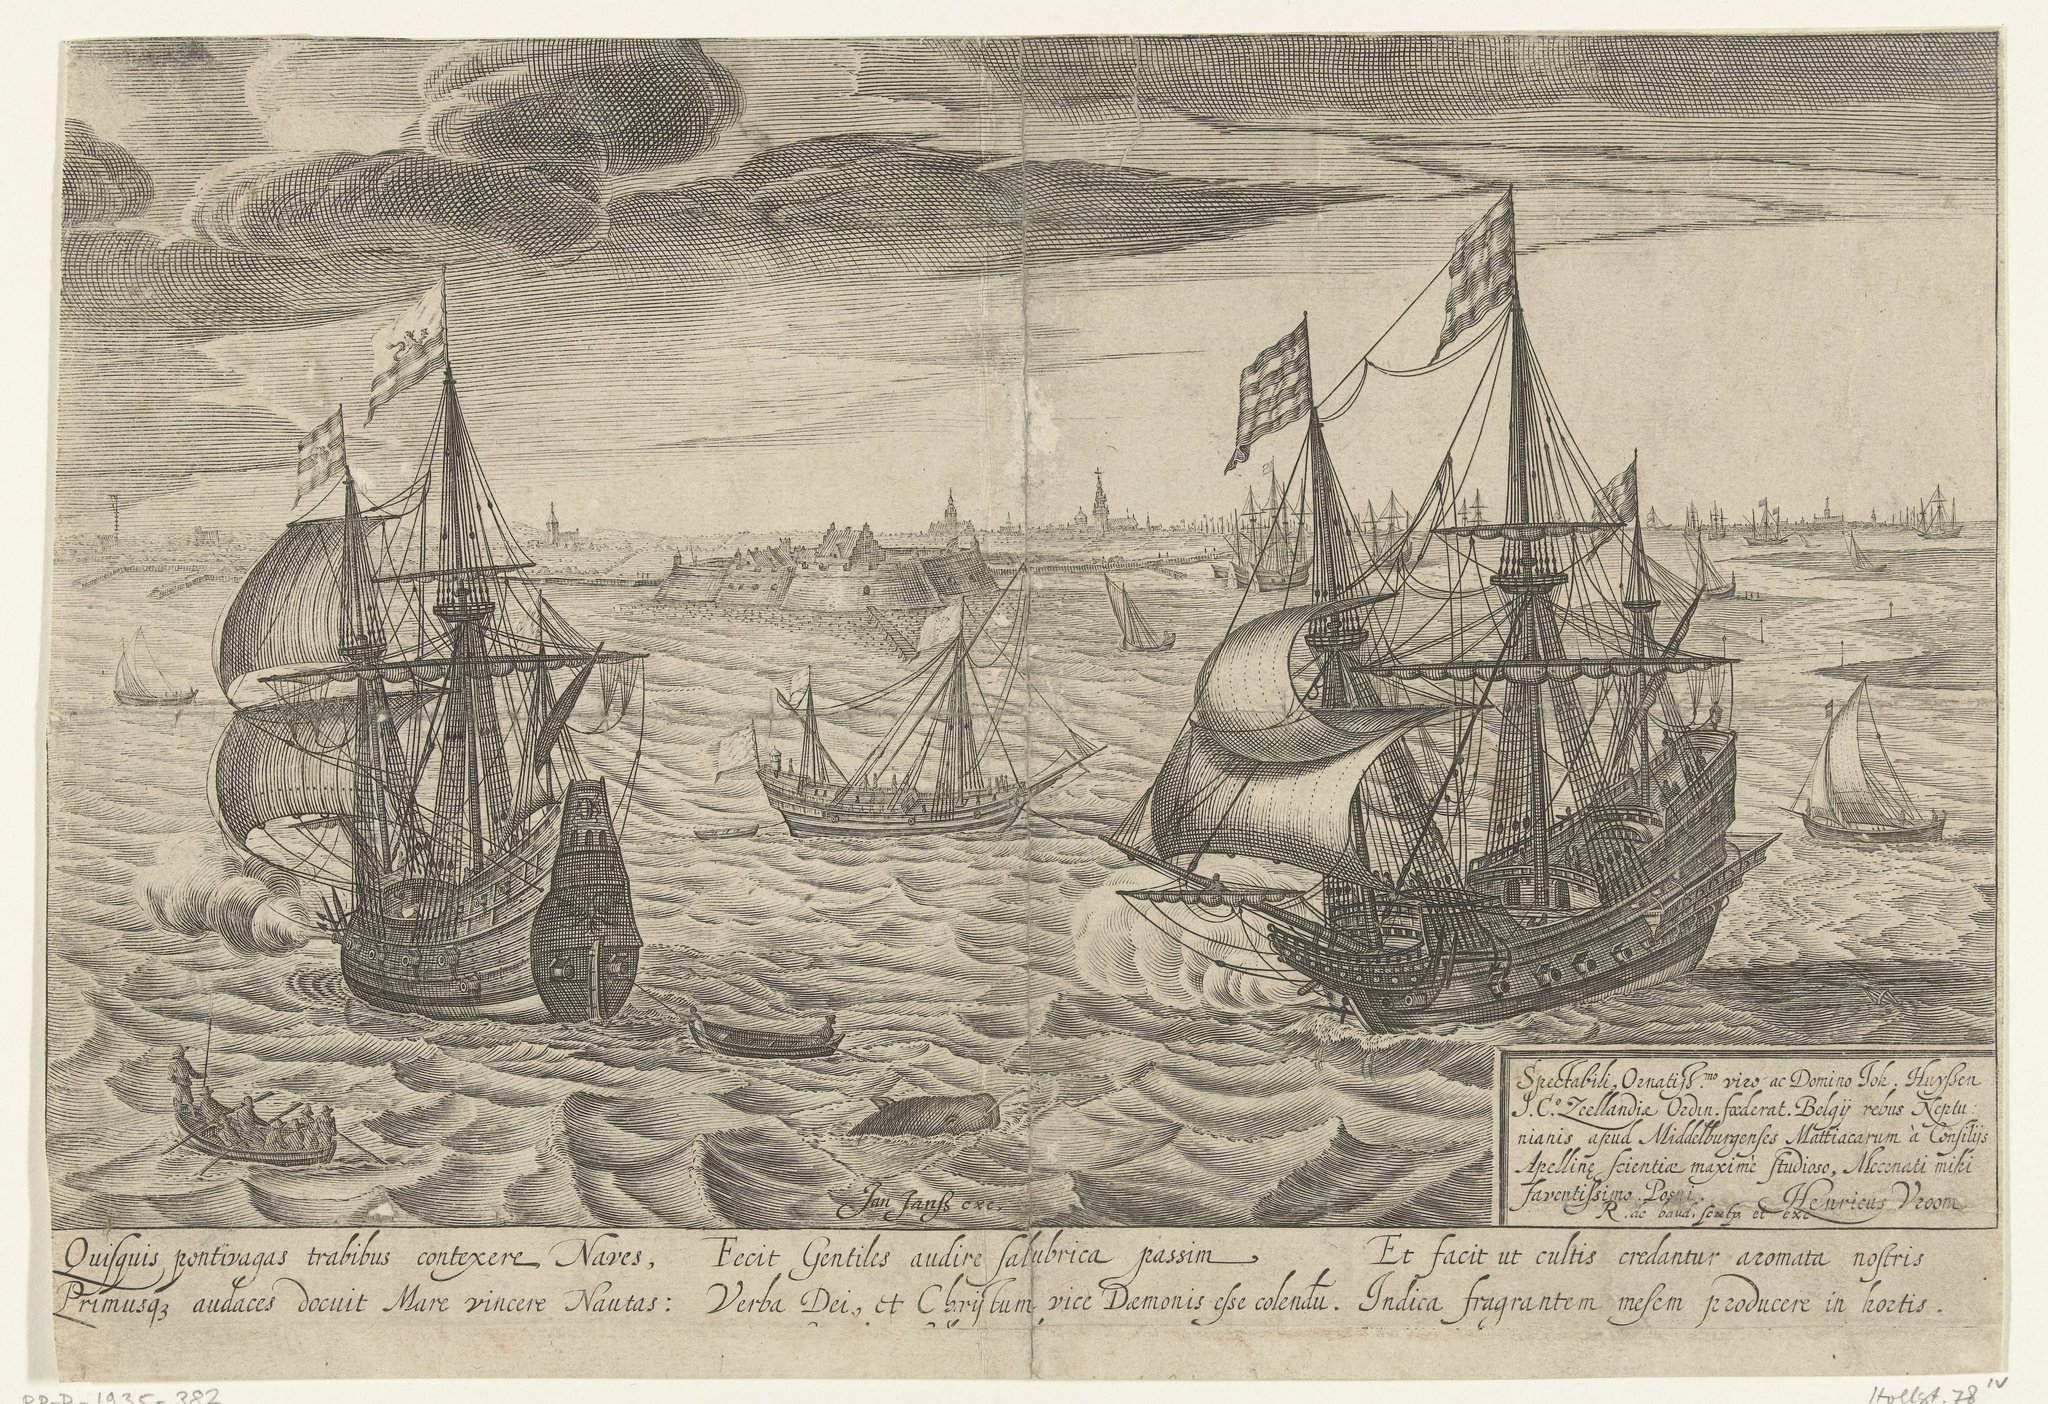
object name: print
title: Marine met gezicht op het fort van Rammekens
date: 1591-1659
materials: paper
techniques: engraving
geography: northern netherlands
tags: warfare; military affairs (+ naval force), middelburg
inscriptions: inscription: ‘Zelandia Illustra. I. 645’, collector's mark: Lugt 2760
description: Zeevloot met gezicht op het fort van Rammekens, met Middelburg en Veere op de achtergrond.